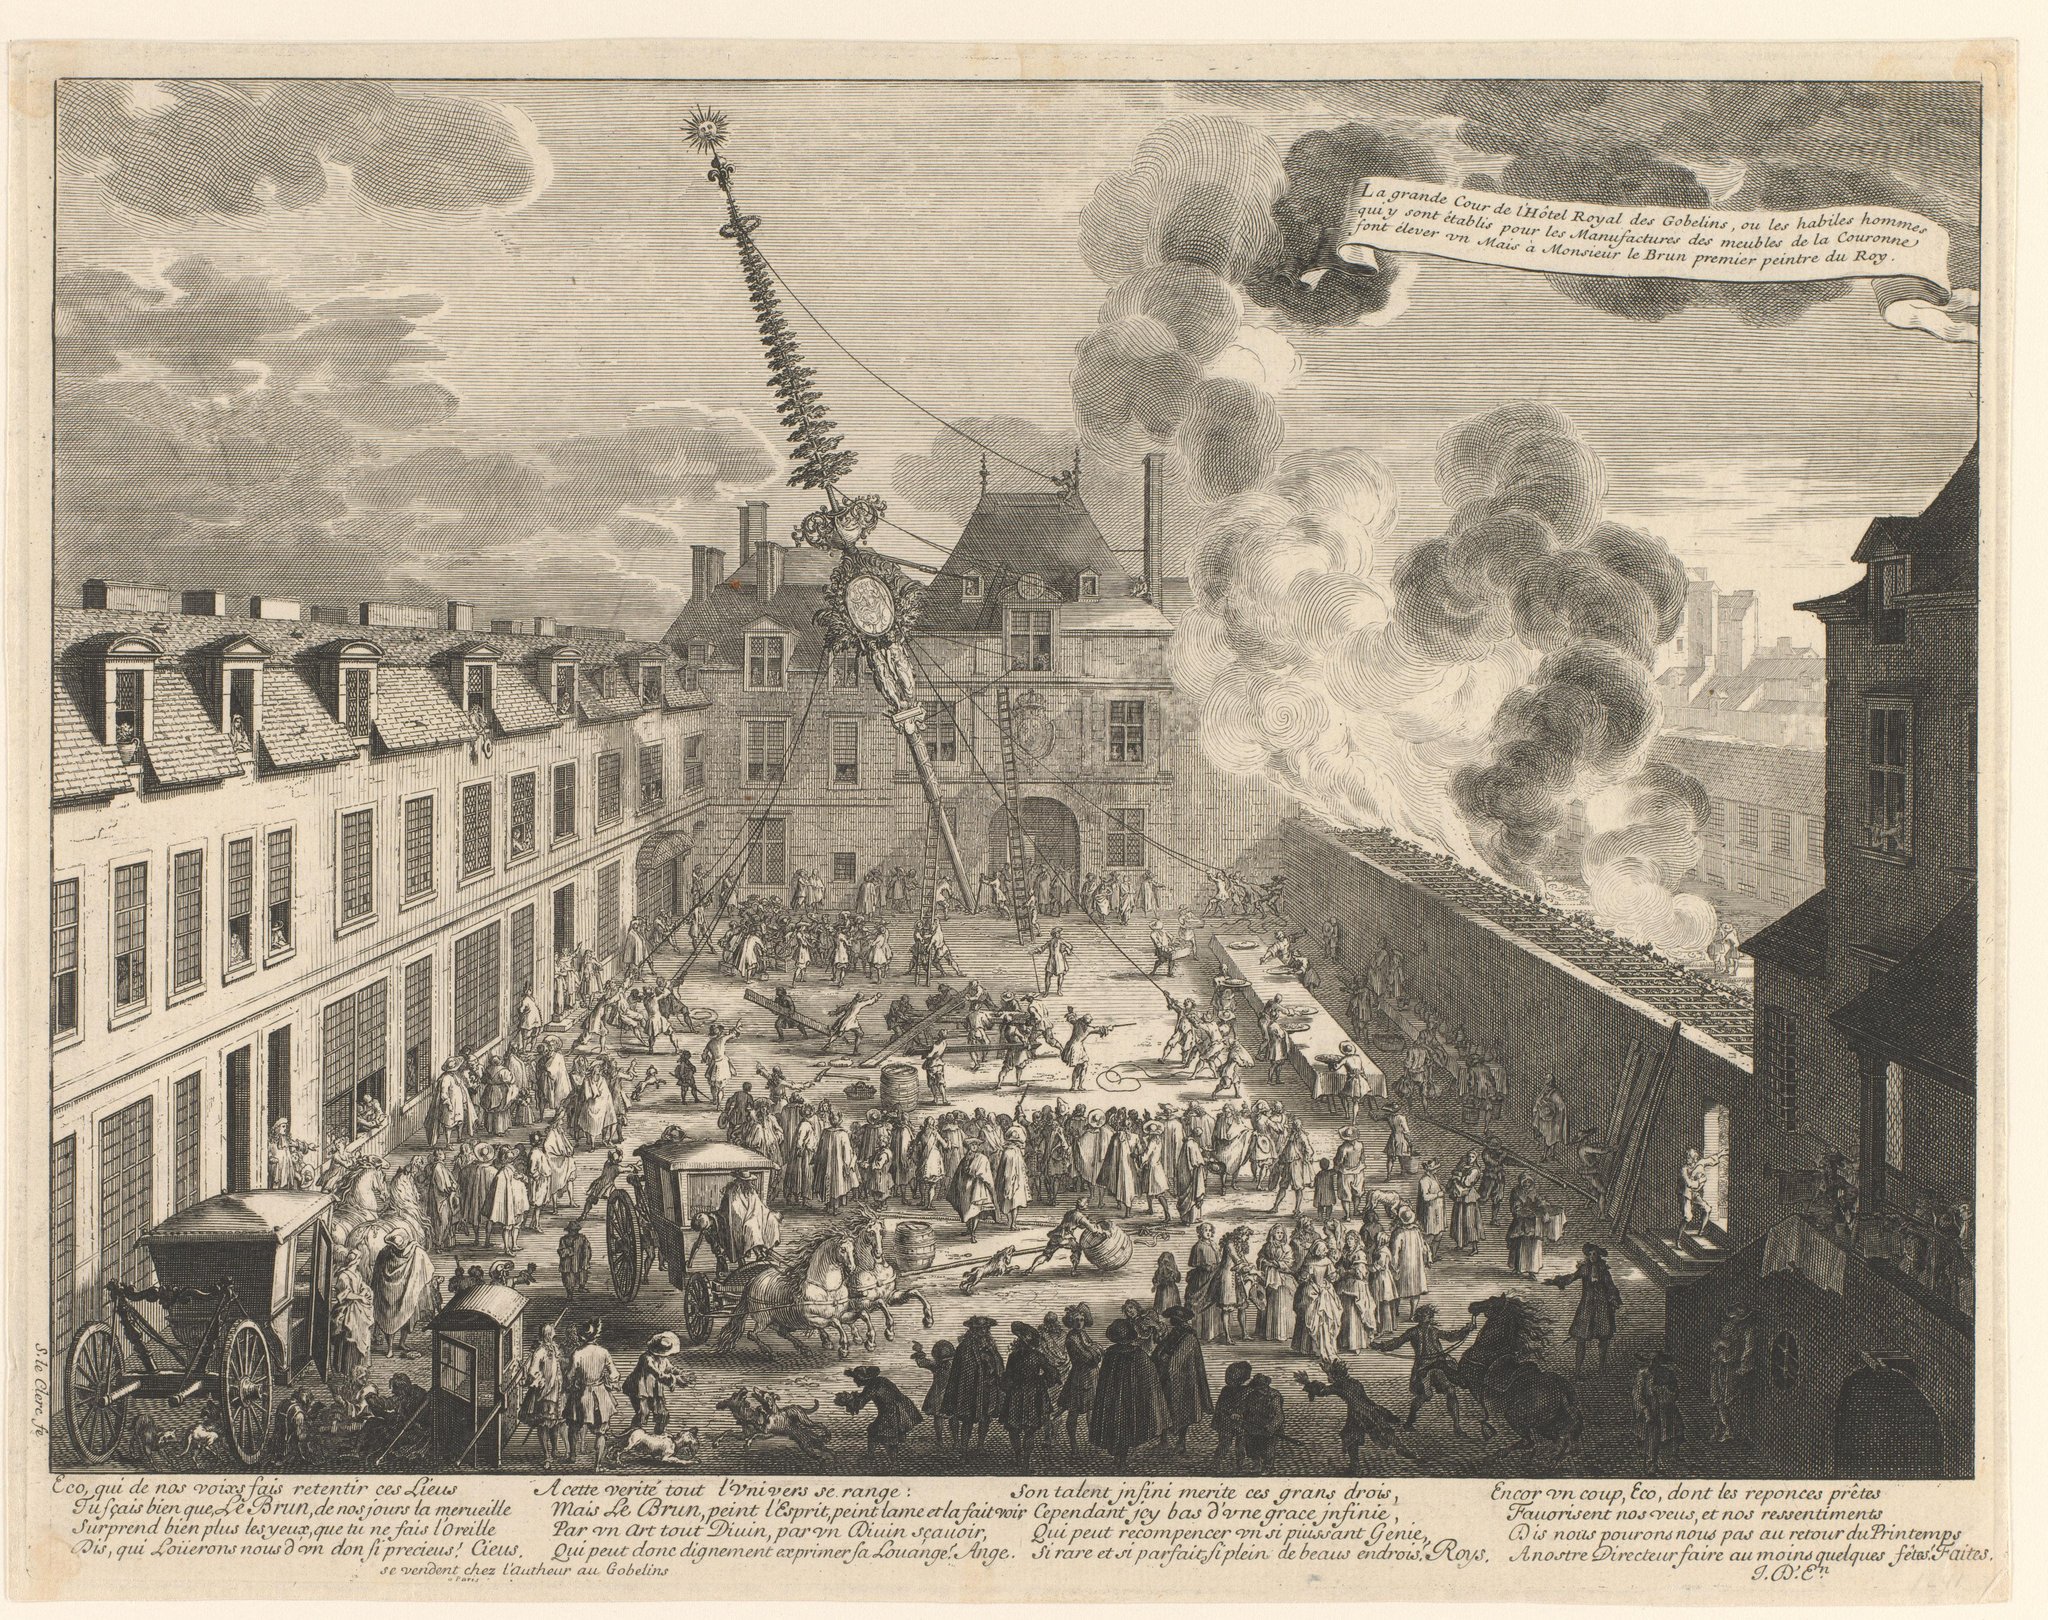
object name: print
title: Oprichting van de meiboom van de Gobelins ter ere van Charles le Brun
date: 1647-1714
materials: paper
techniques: engraving, etching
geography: paris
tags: maypole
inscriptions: collector's mark: Lugt 2228